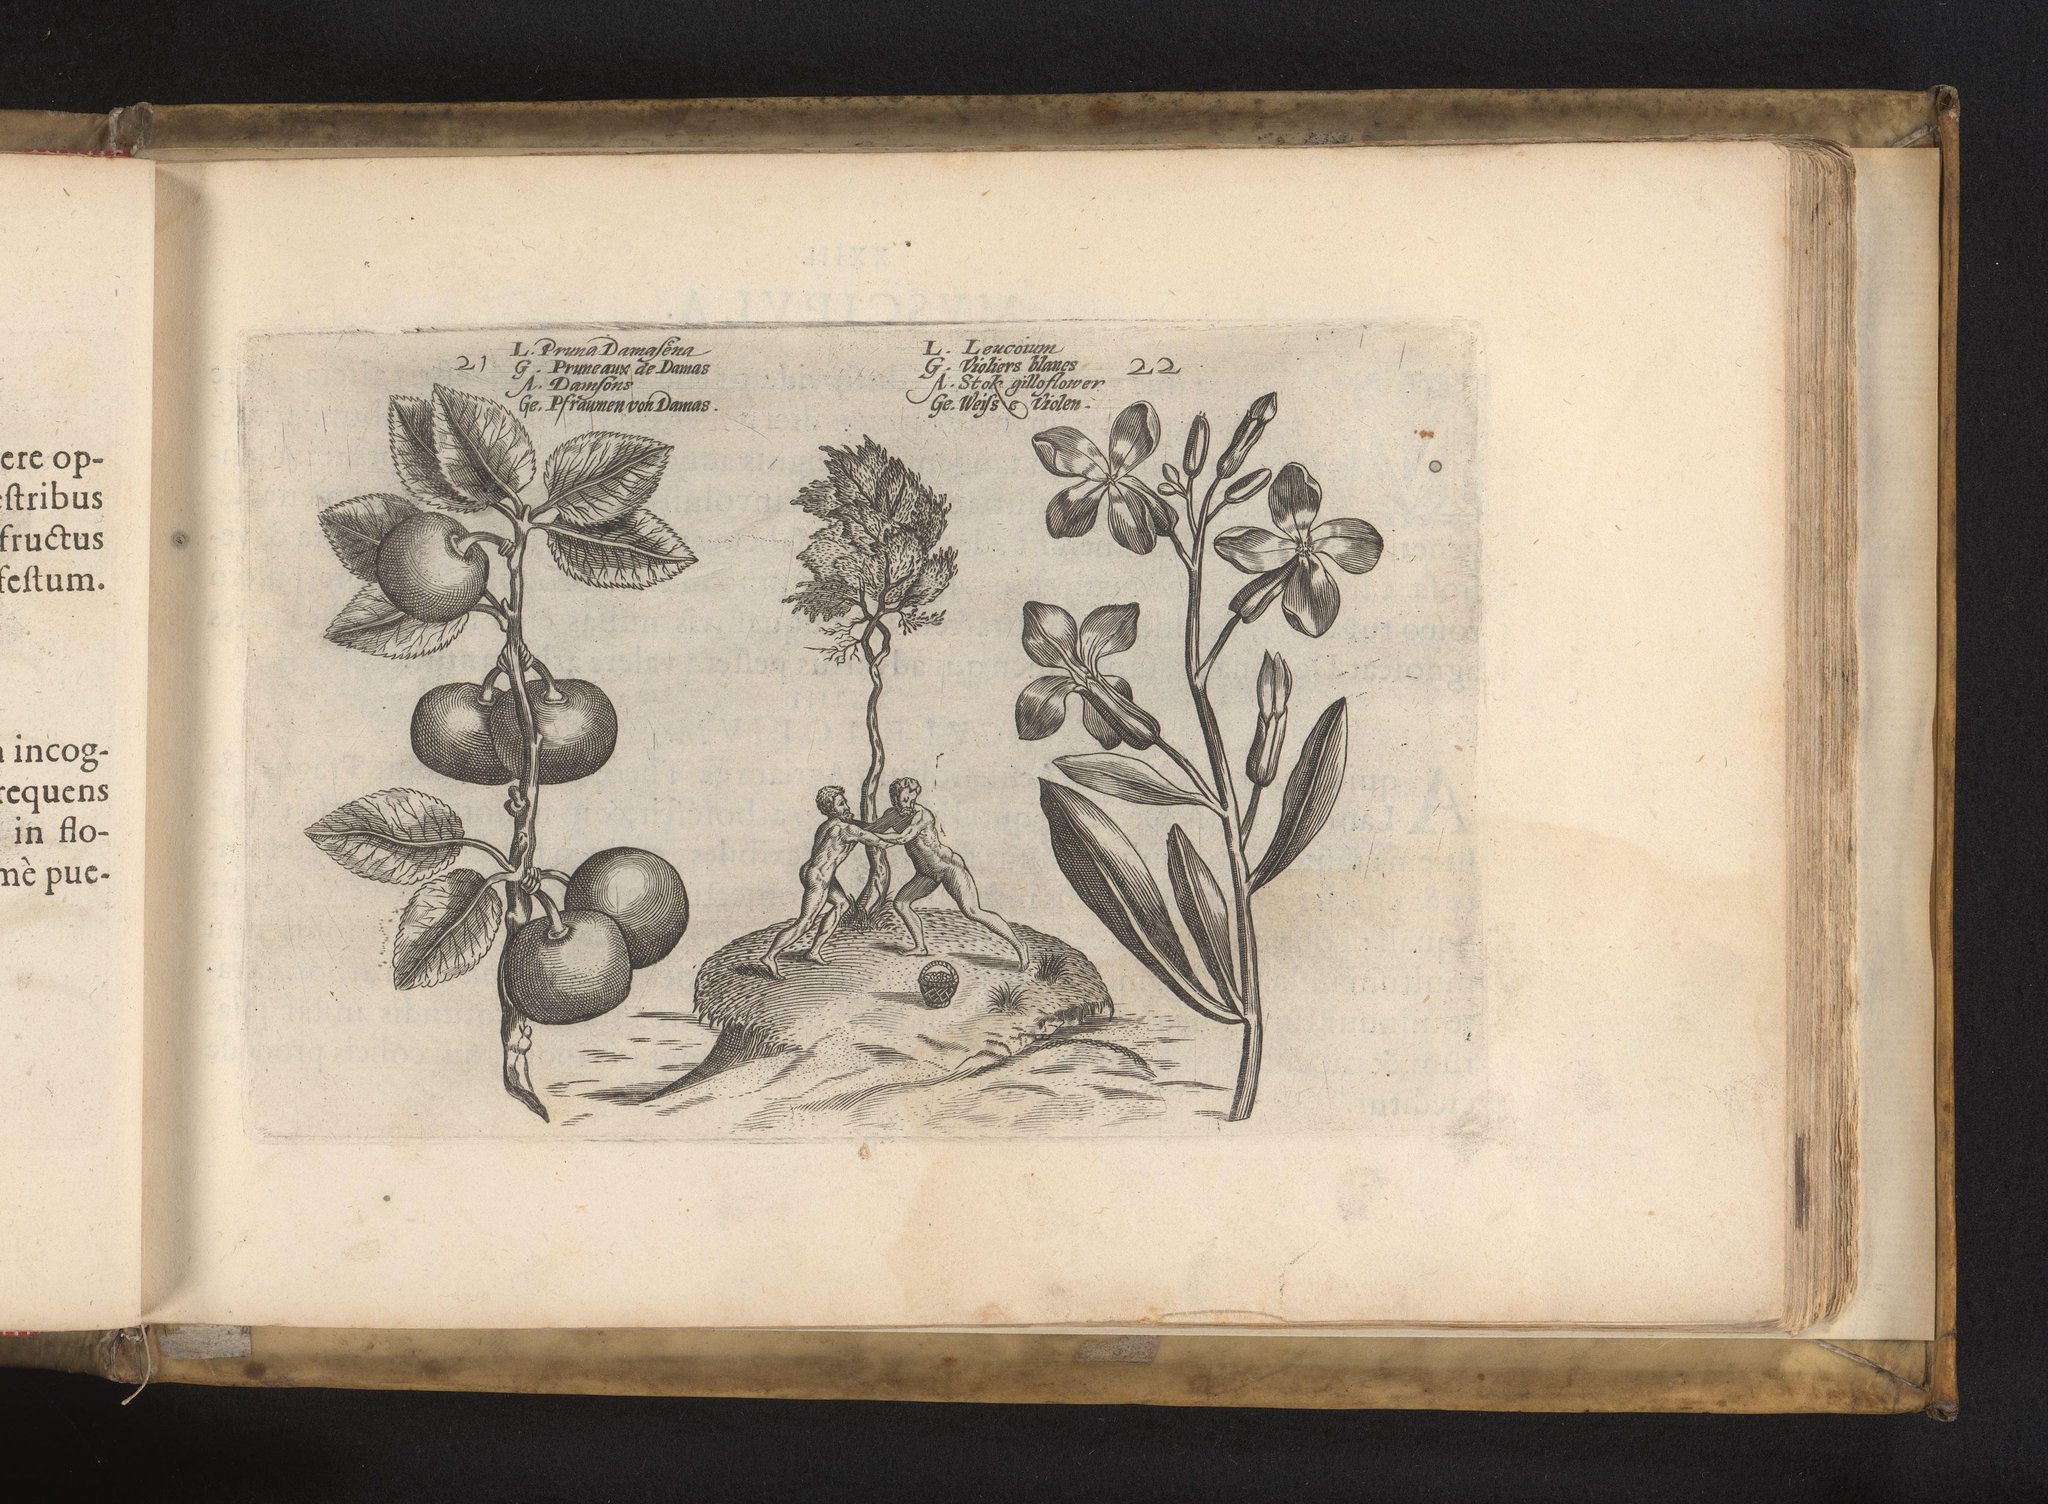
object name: page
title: Damastpruim en violier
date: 1617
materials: paper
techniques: engraving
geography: arnhem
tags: flowers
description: Prent uit: Passe, Crispijn van de (II). Hortus floridus in quo rariorum & minus vulgarium florum icones ad vivam veramque formam. Arnhem: Johannes Janssonius, 1617.